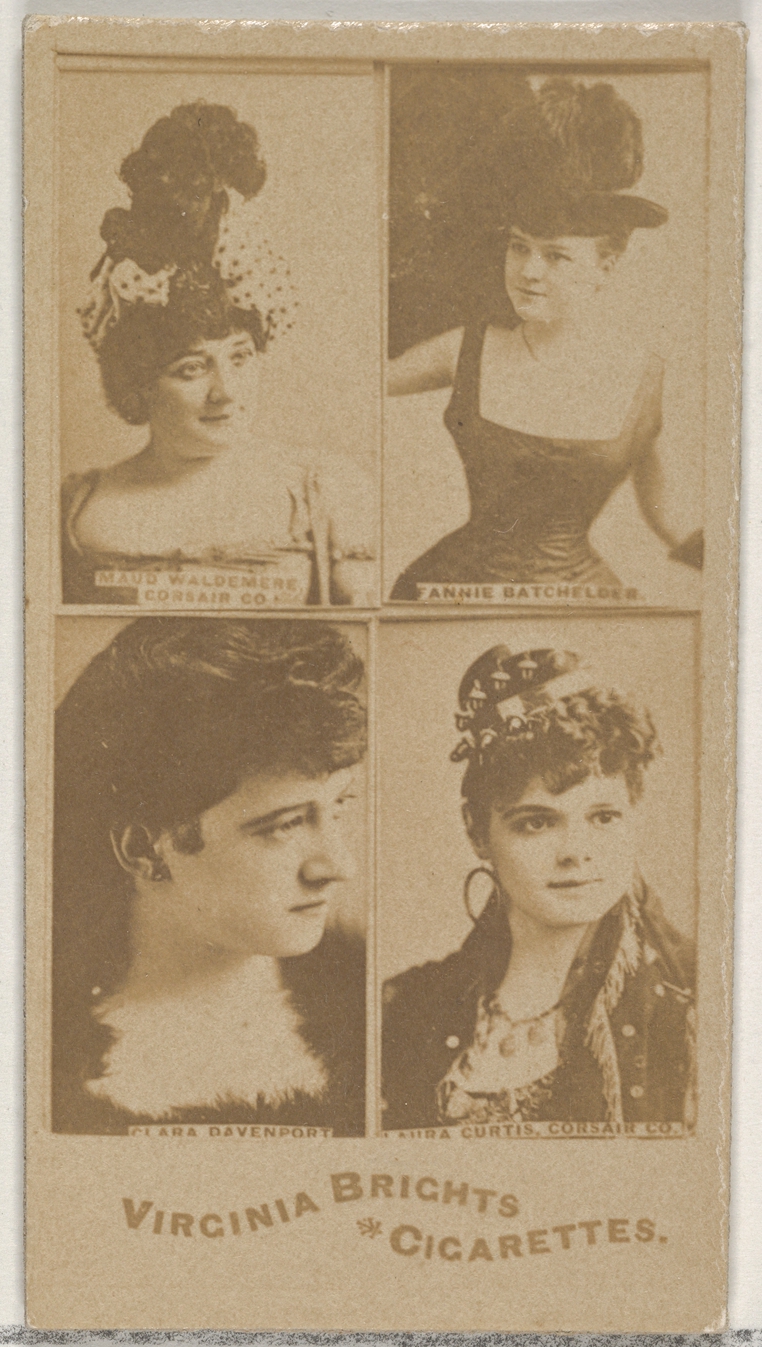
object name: photograph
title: Maud Waldemere, Corsair Co./ Fannie Batchelder/ Clara Davenport/ Laura Curtis, Corsair Co., from the Actors and Actresses series (N45, Type 4) for Virginia Brights Cigarettes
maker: allen & ginter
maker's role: publisher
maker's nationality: american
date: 1888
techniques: albumen silver print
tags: girls,portraits,women